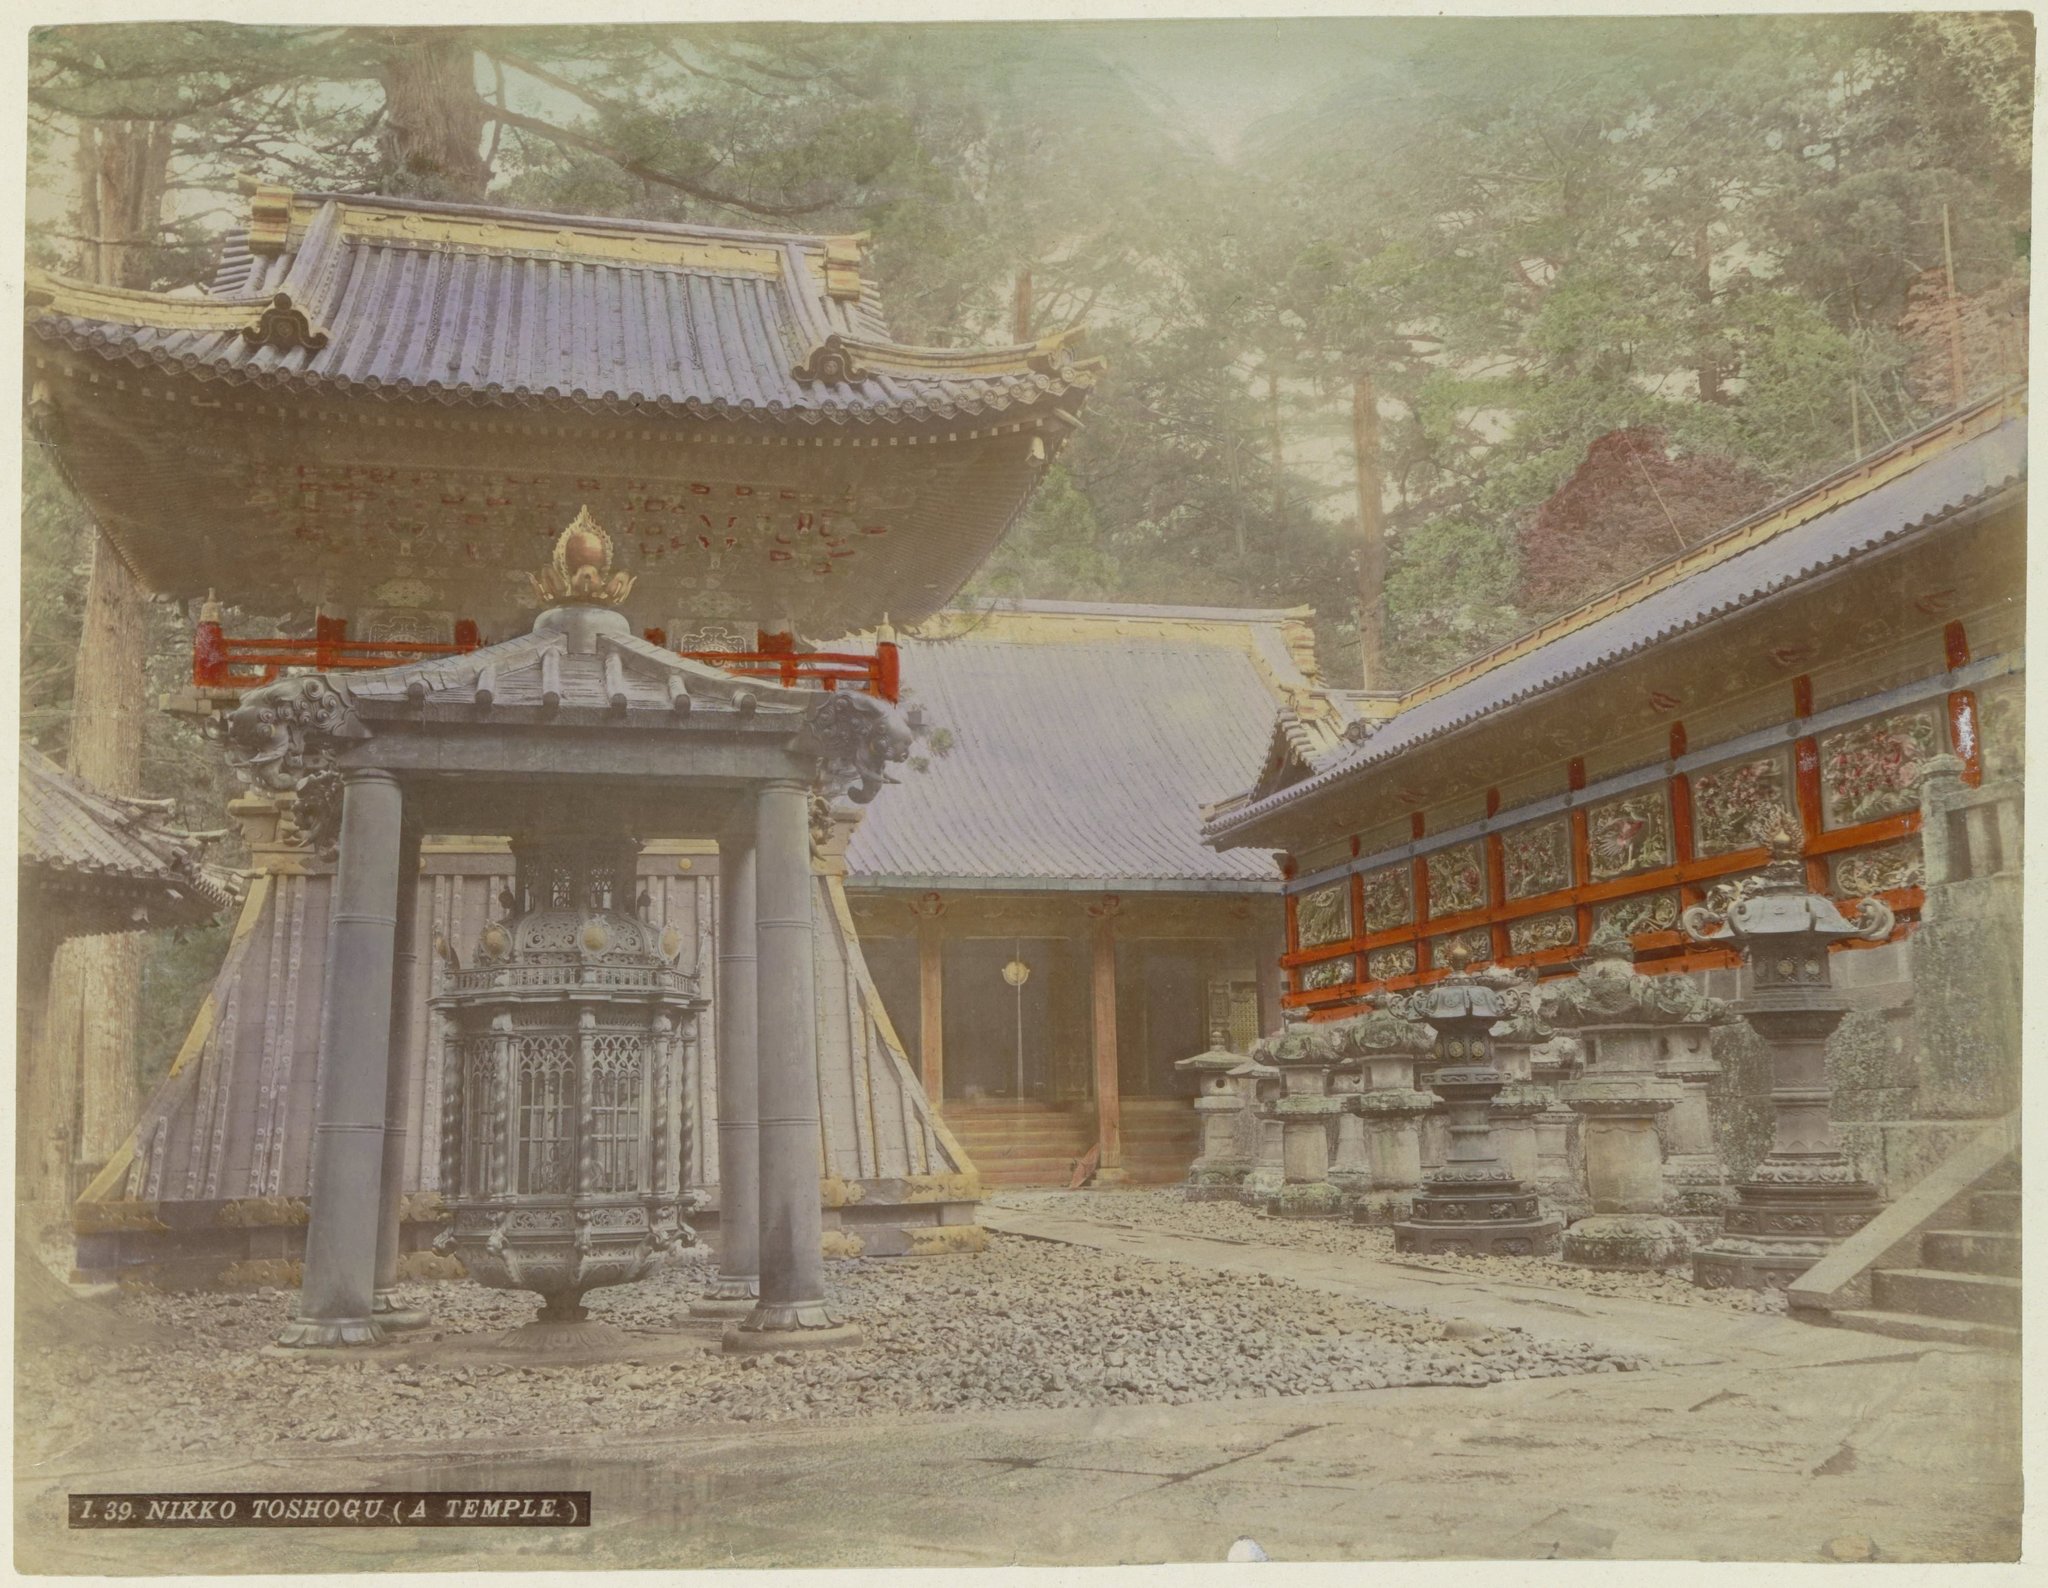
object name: photograph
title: Tempel van Nikko Toshogu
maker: Anonymous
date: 1870-1900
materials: cardboard, paper, photographic support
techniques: albumen print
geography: nikko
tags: temple, shrine ~ hinduism, buddhism, jainism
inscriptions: negative number: ‘I. 39.’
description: Onderdeel van Reisalbum met foto's van bezienswaardigheden in Japan.